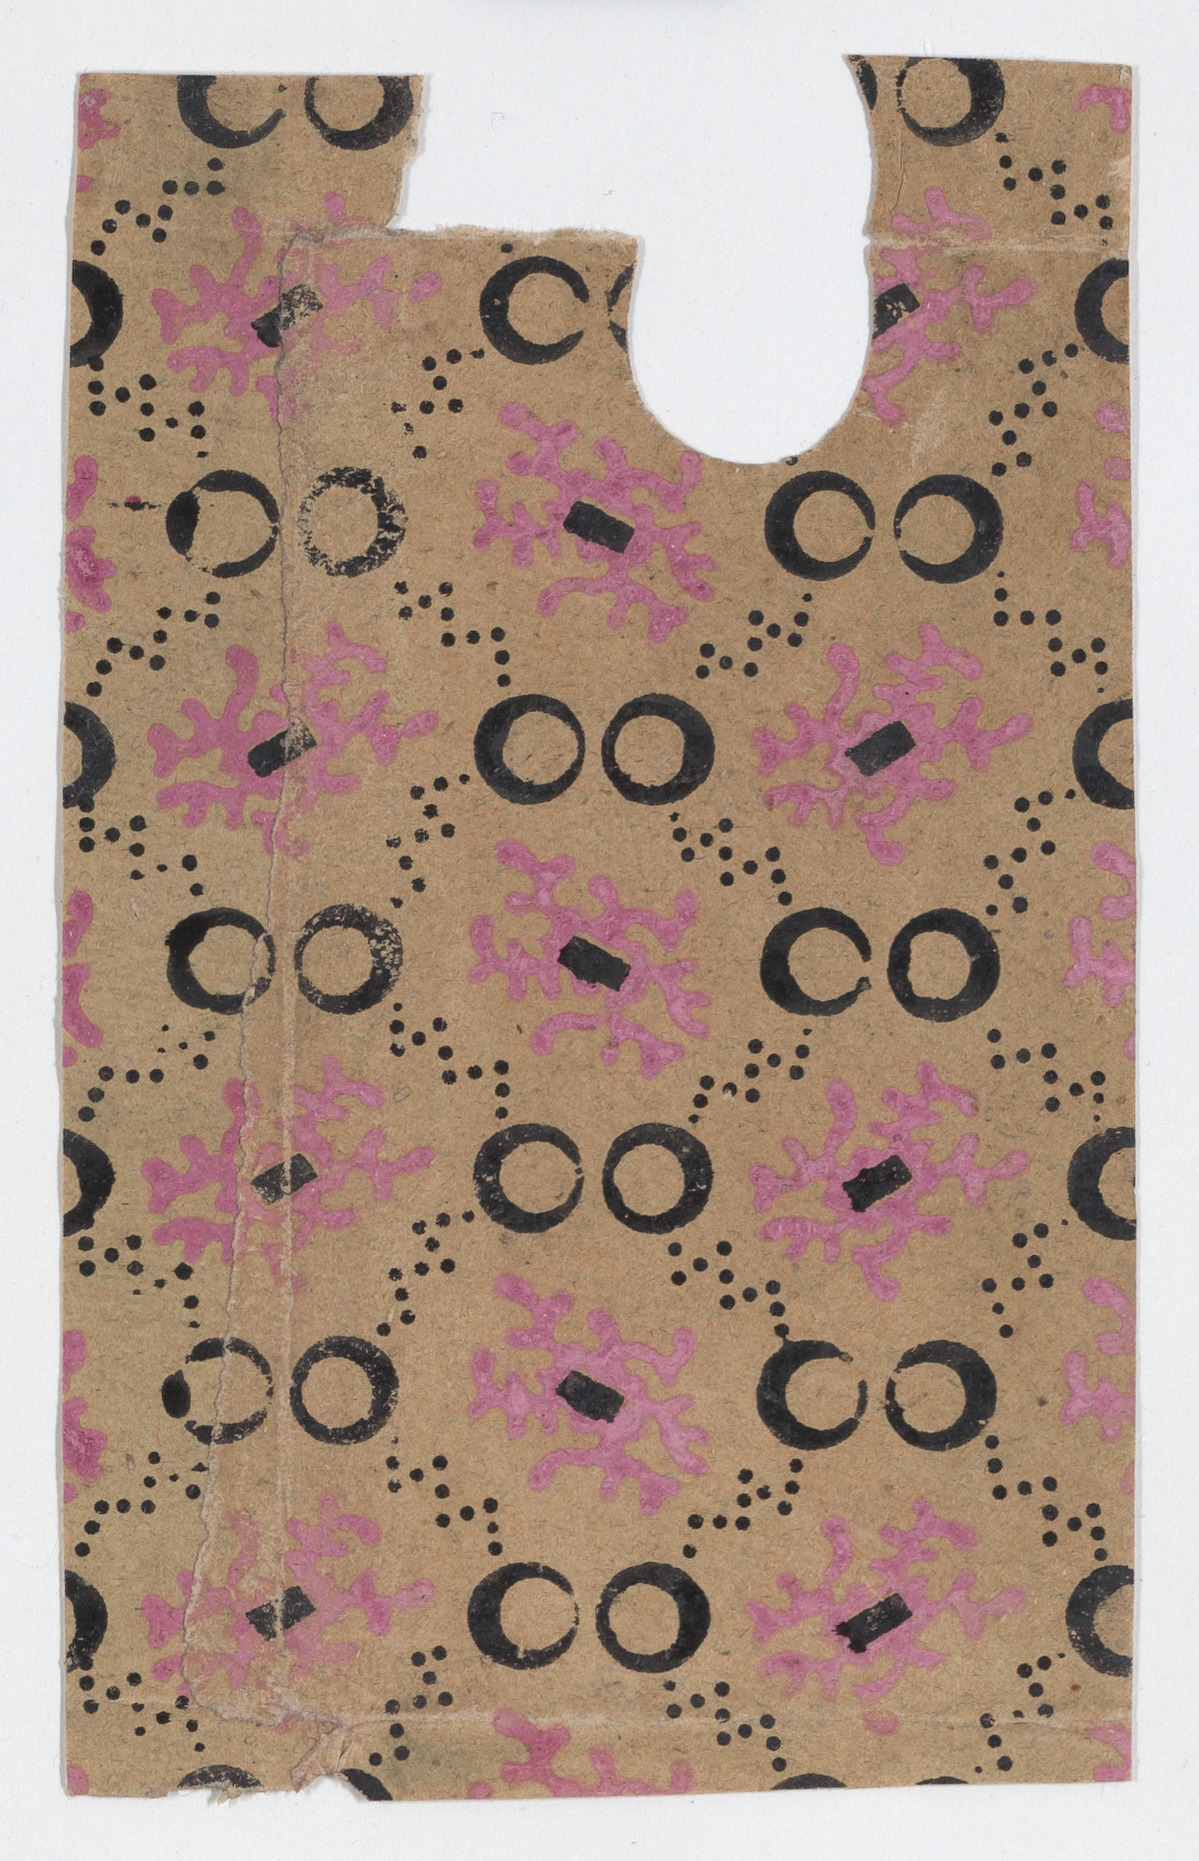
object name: print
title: Sheet with pattern of coral and circles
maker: Anonymous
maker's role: artist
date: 1801-1900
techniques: relief print